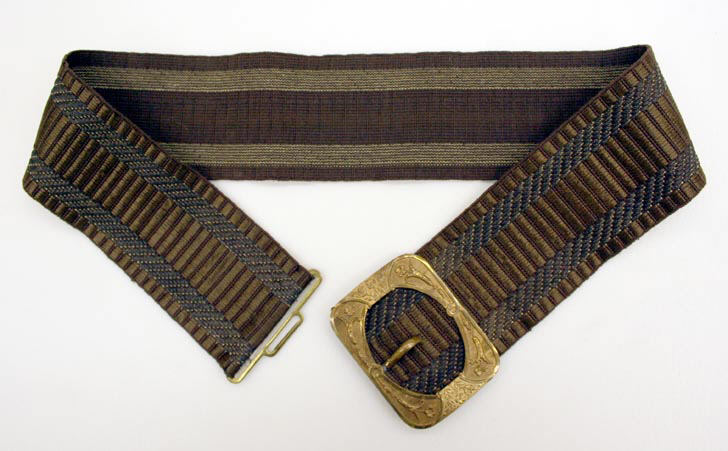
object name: belt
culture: french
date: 1830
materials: cotton, metal, silk